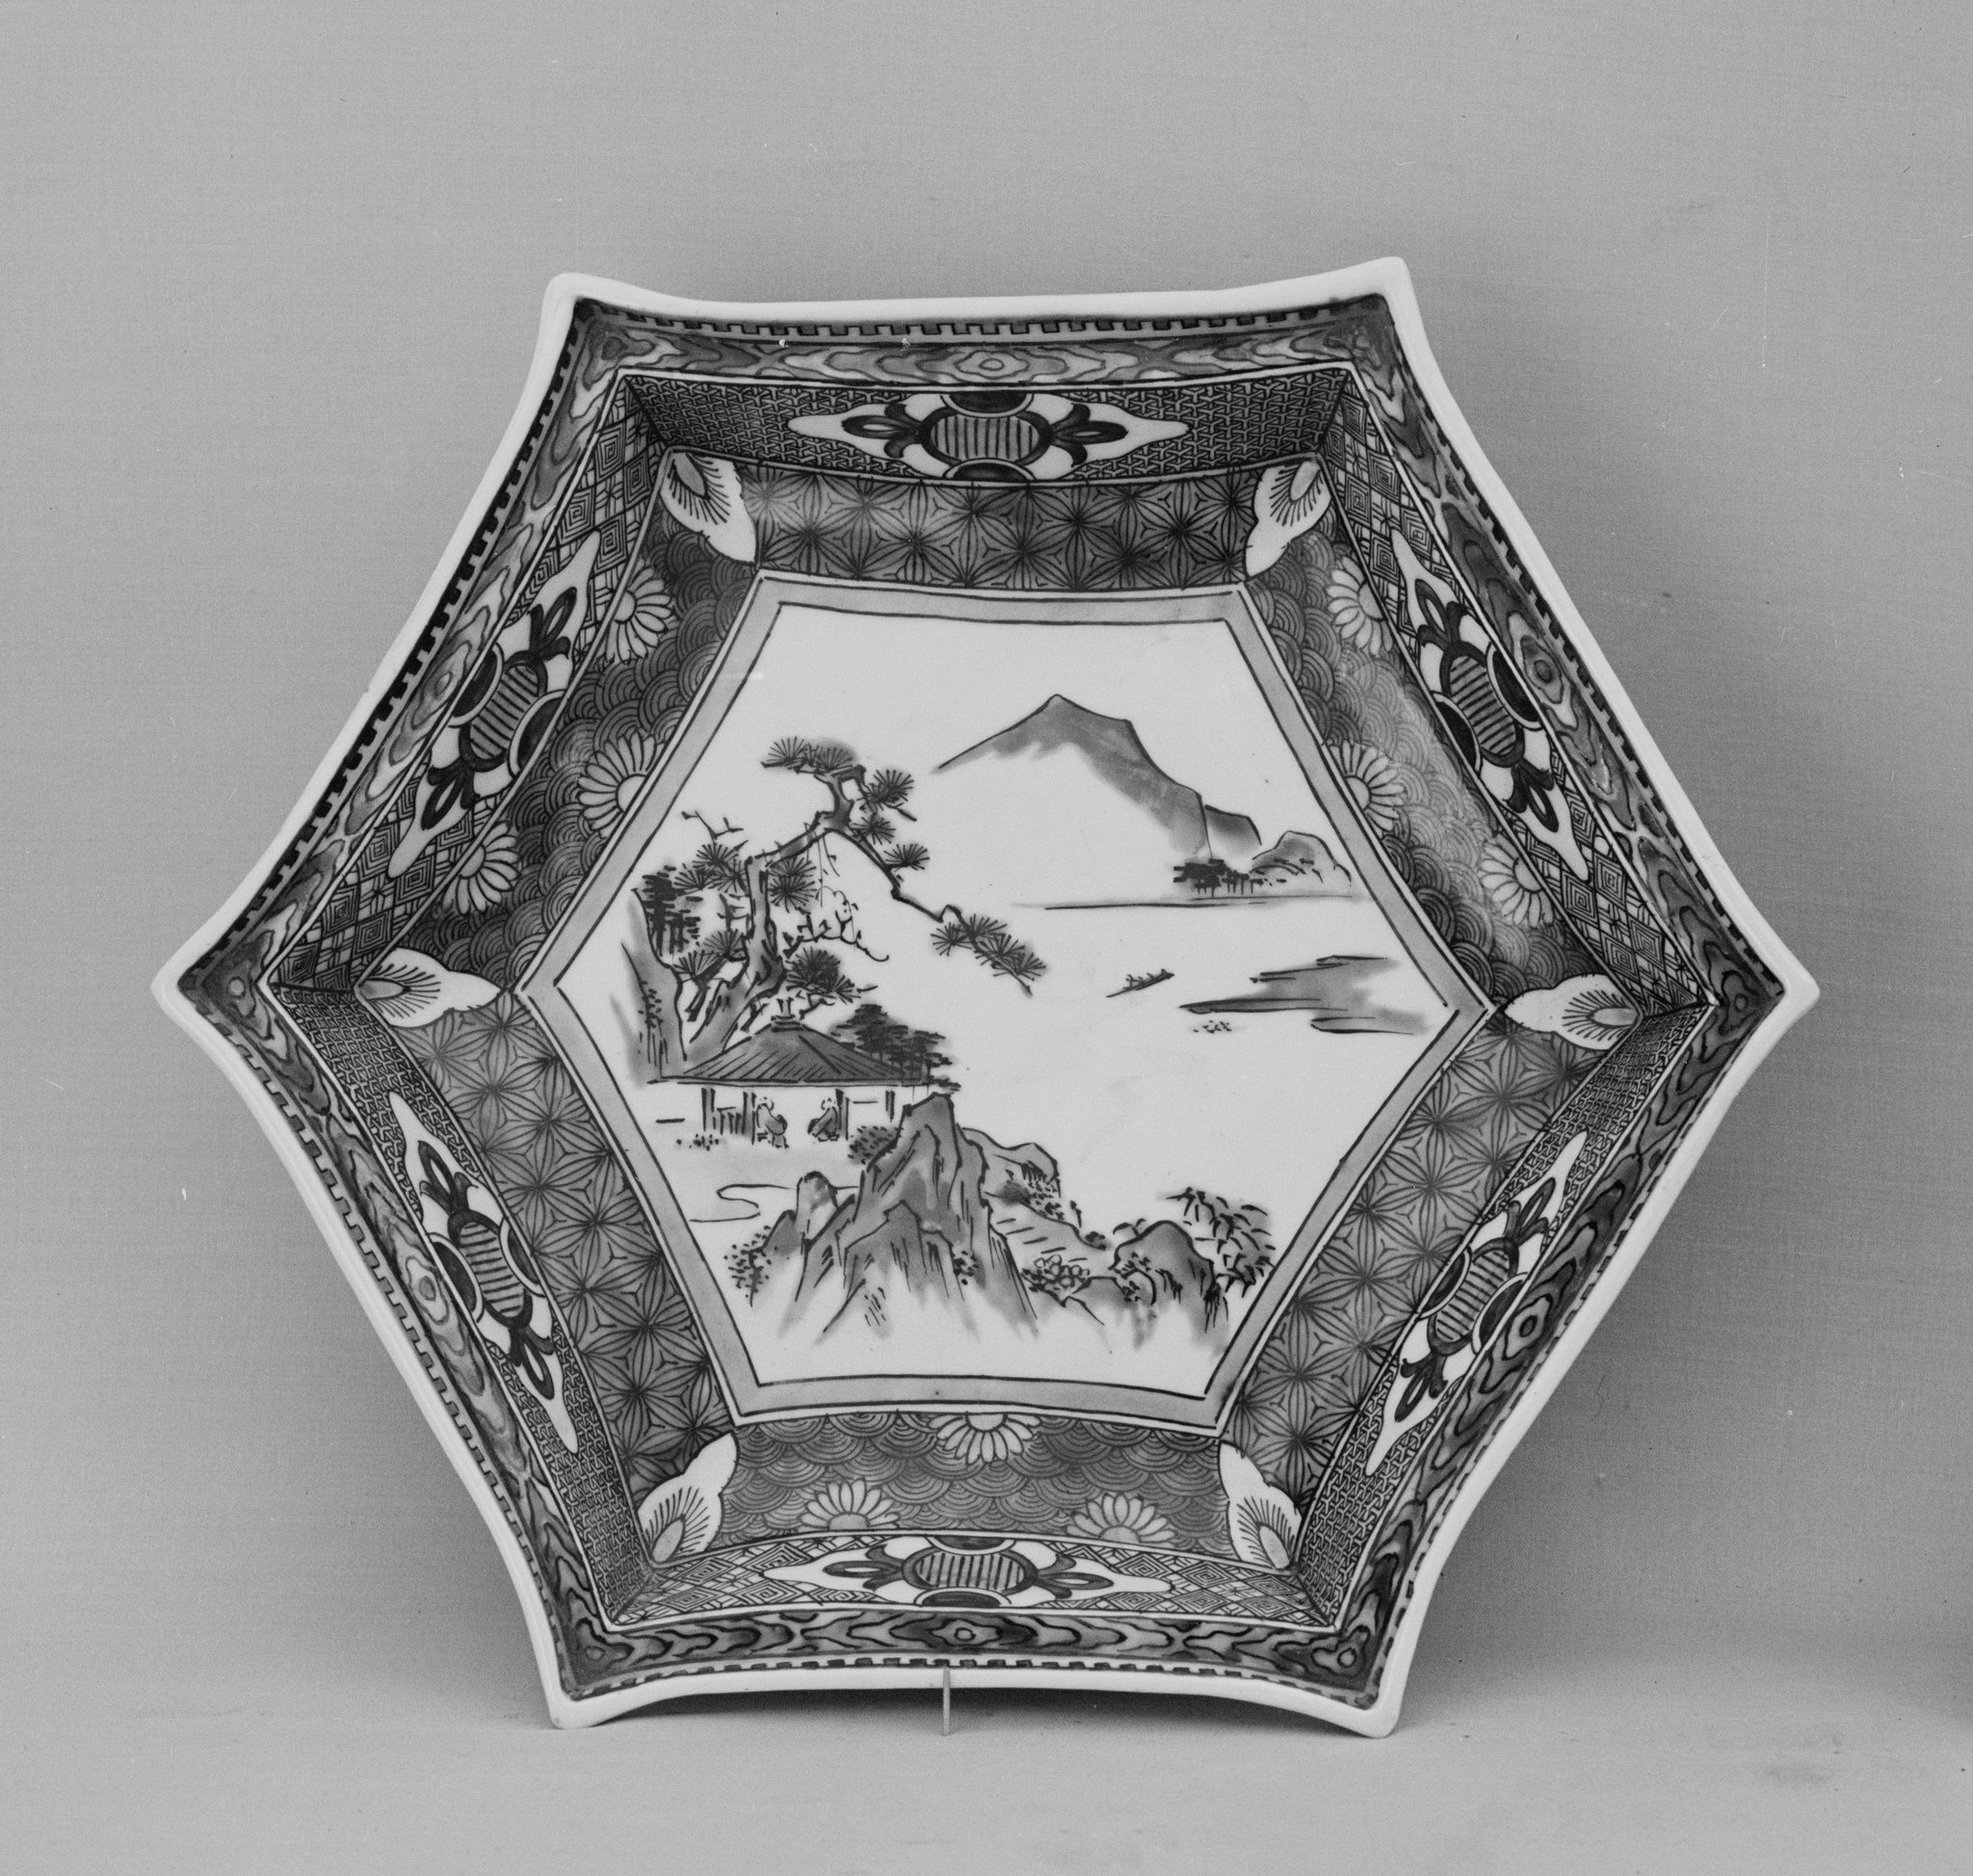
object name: dish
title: Hexagonal Dish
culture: japanese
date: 1865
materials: enamel, glaze, gold, iron, porcelain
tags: landscapes